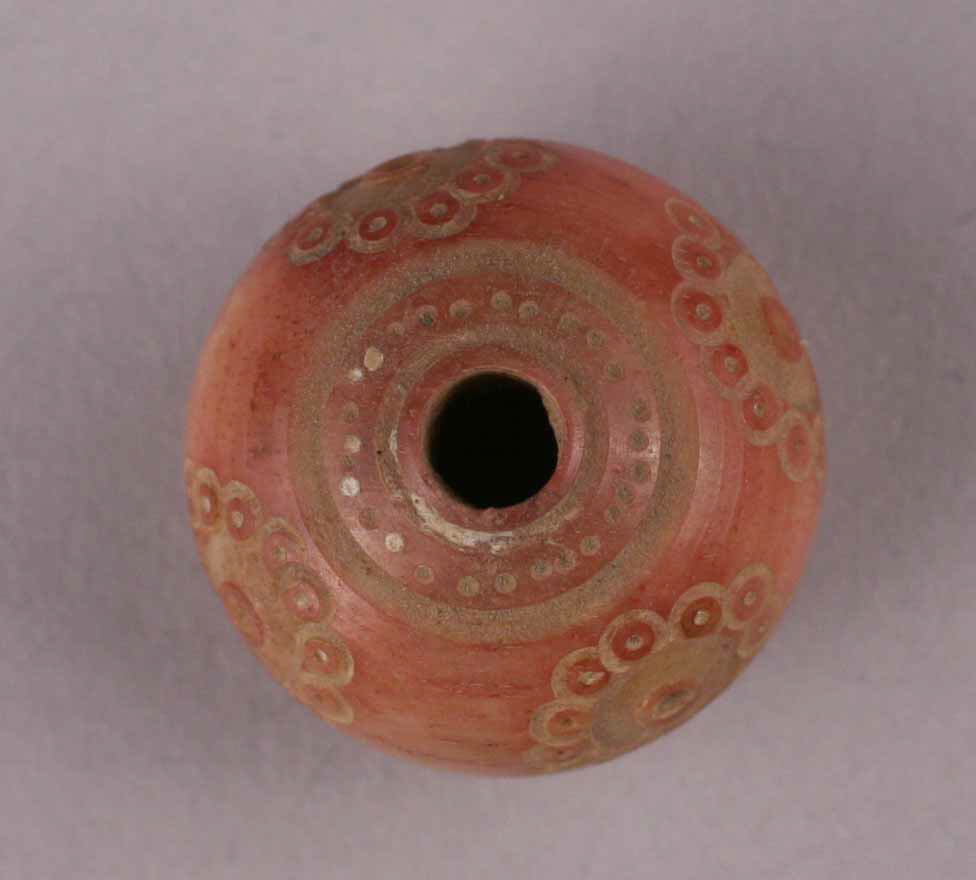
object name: button or bead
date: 801-1000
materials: bone, ivory, paint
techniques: incising, inlay, tinting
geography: iran